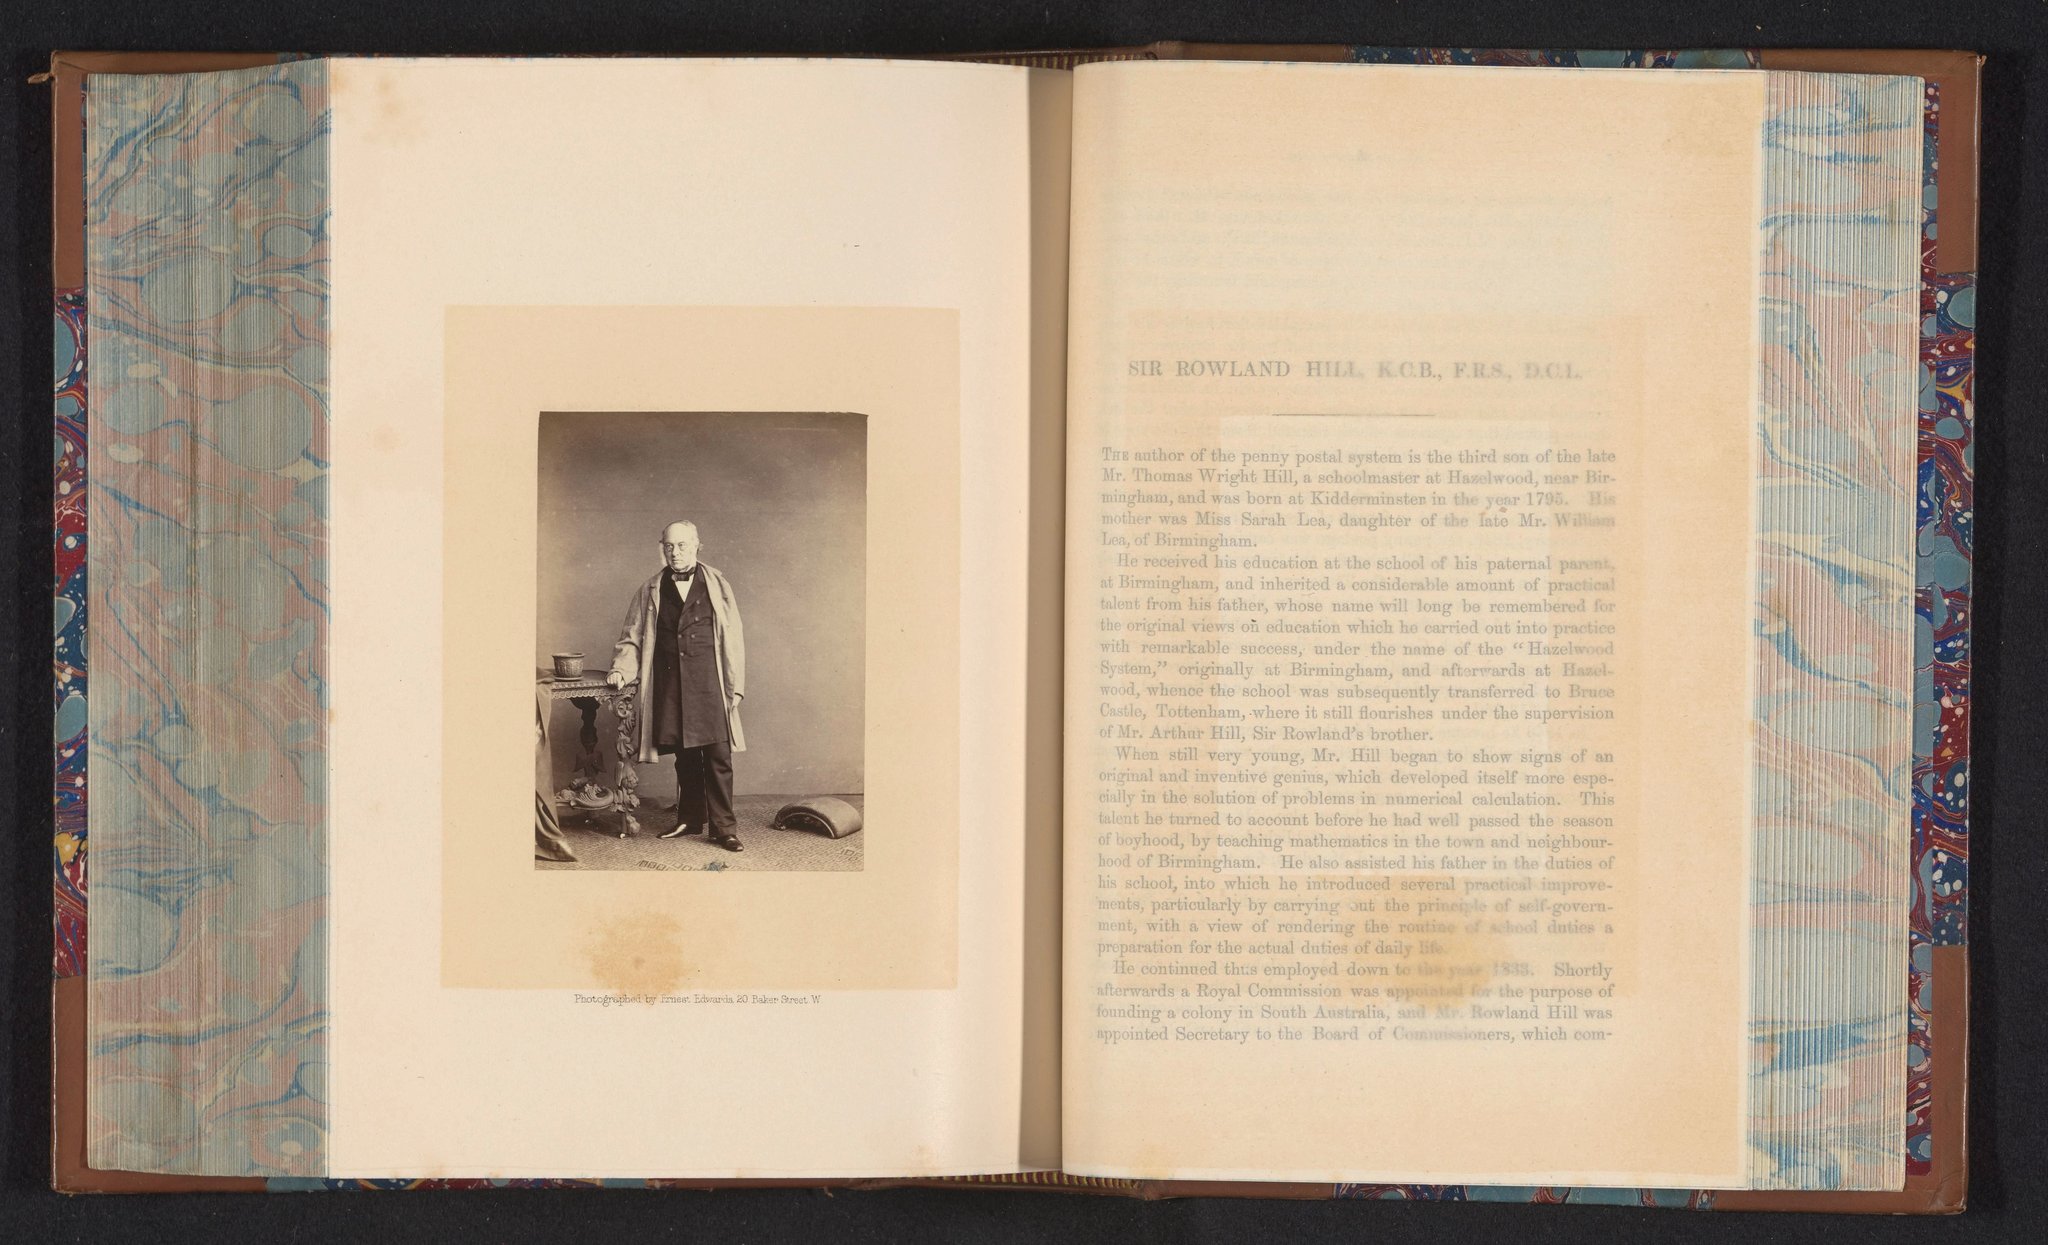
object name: page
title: Portret van Rowland Hill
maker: ernest edwards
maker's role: fotograaf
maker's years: 1837-1903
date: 1853-1867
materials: photographic support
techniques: albumen print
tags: scholar, philosopher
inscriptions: name: ‘Photographed by Ernest Edwards, 20, Baker Street. W.’